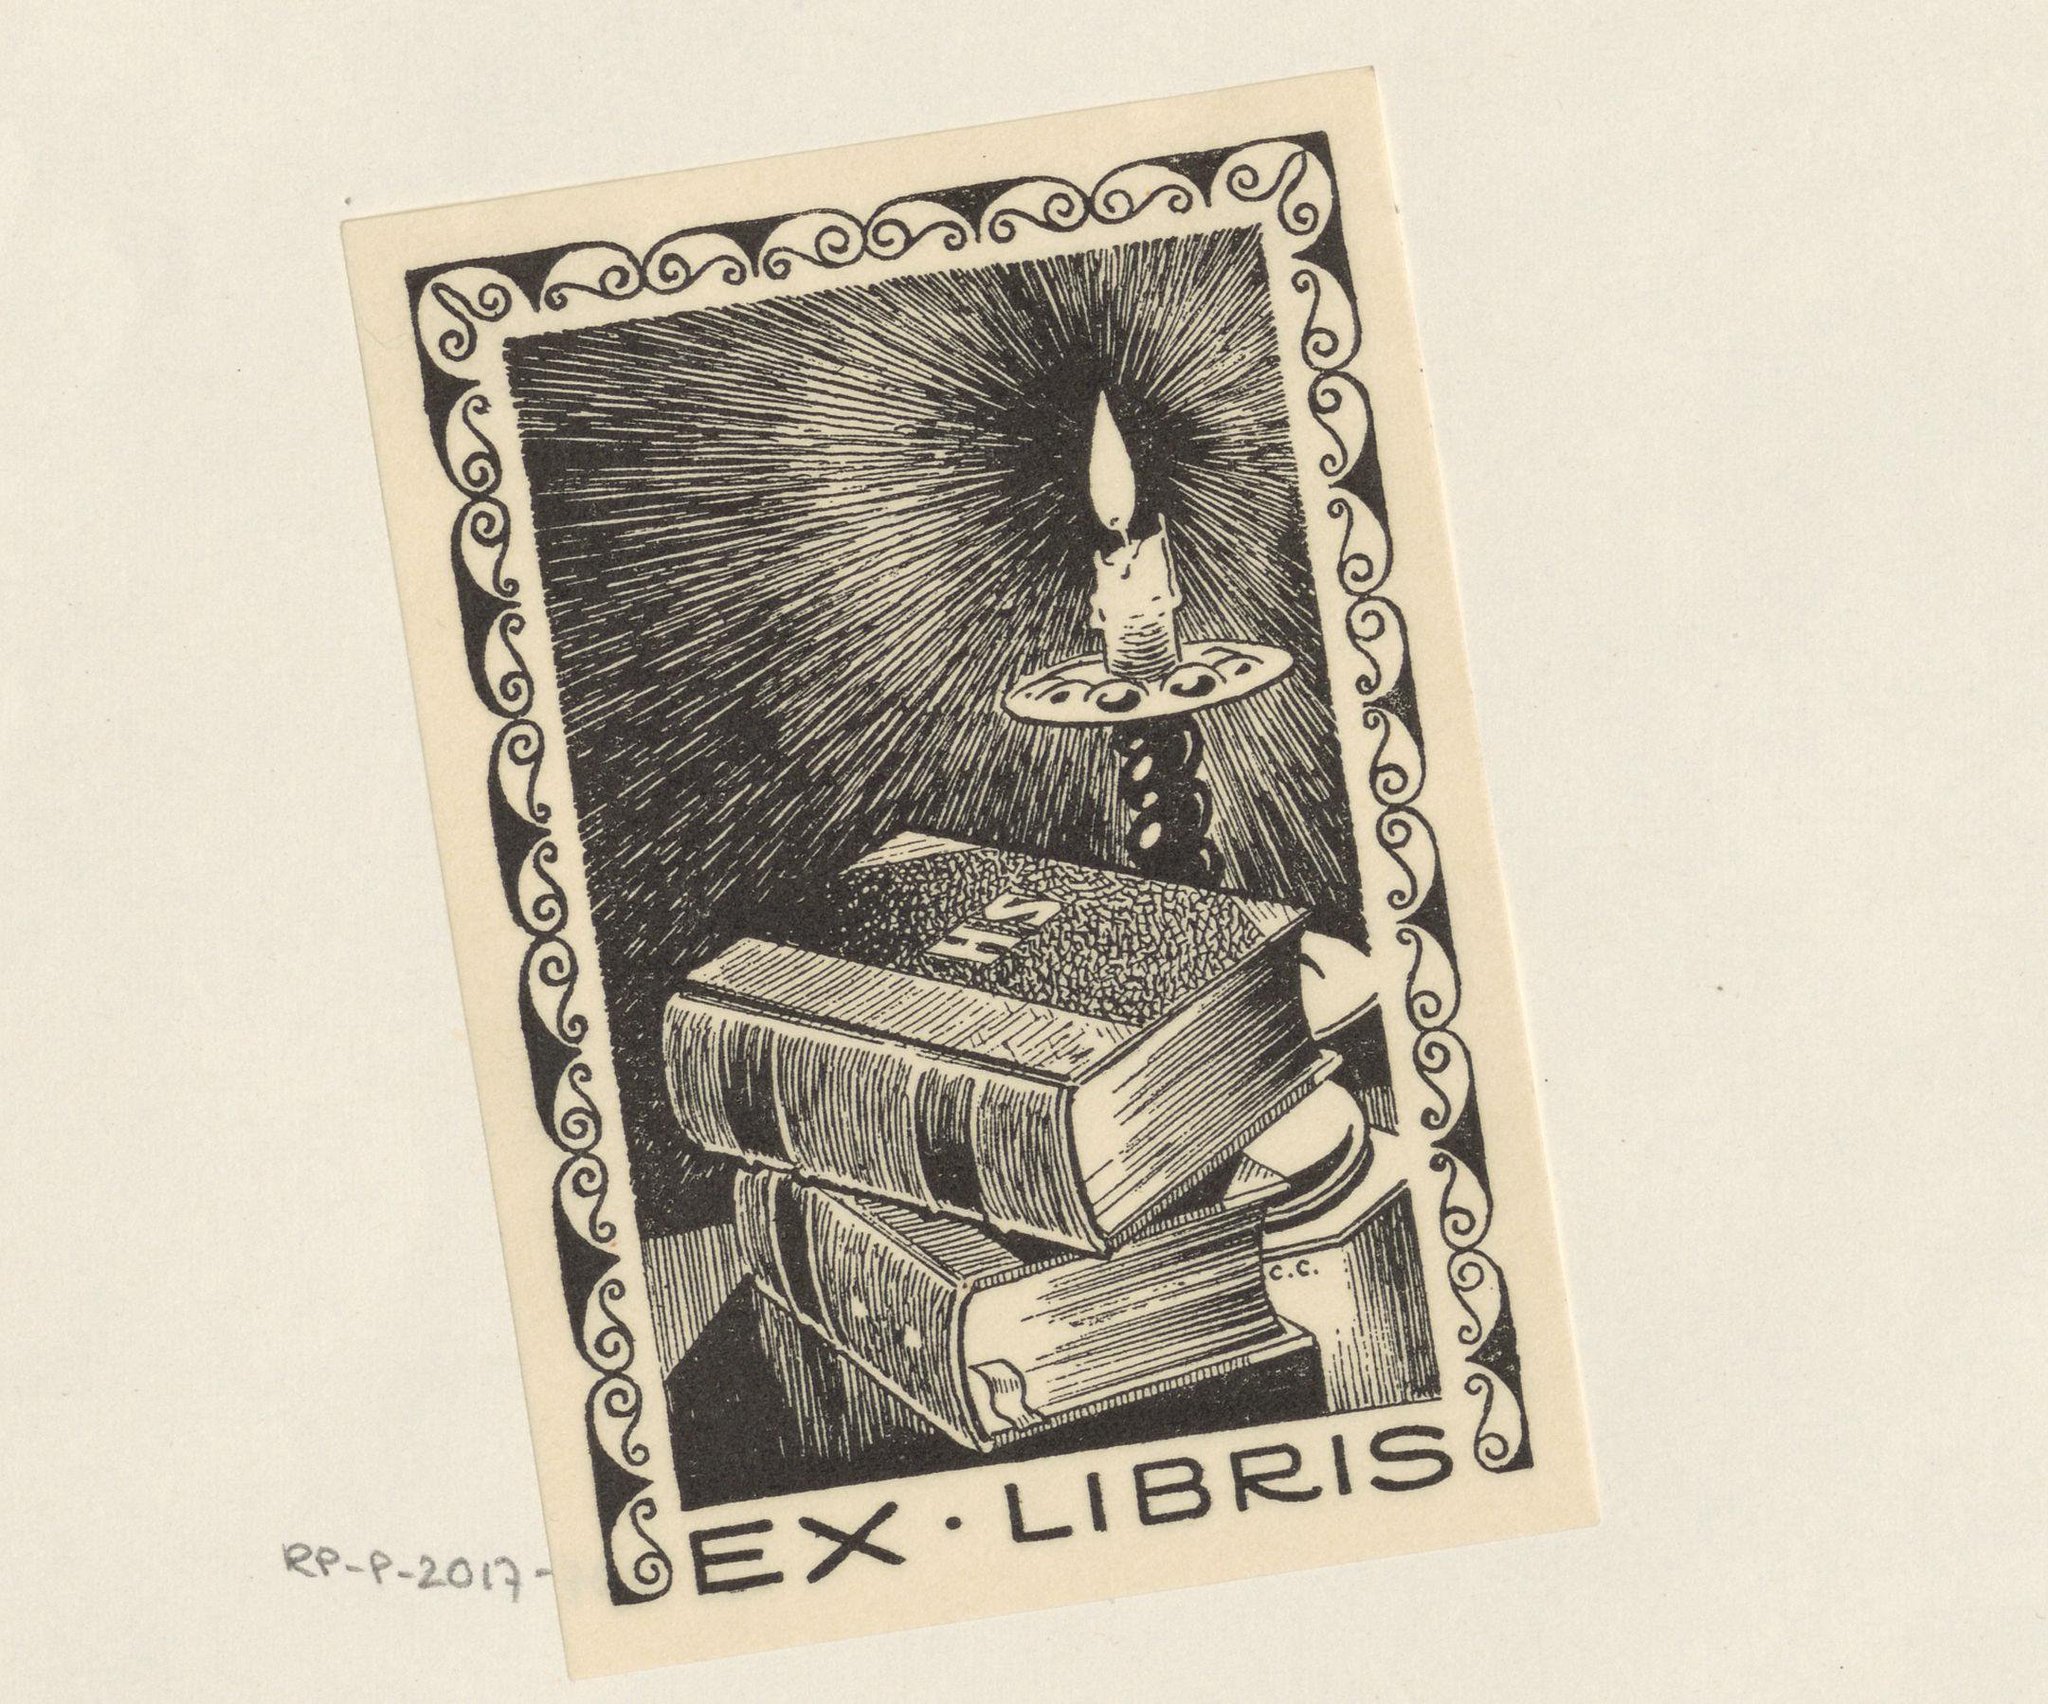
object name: bookplate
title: Ex libris van H.S.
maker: Anonymous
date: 1900-1999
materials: paper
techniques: printing block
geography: netherlands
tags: book, candle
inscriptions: inscription: ‘Q-312 / Doll (?) 18-10-56 X’